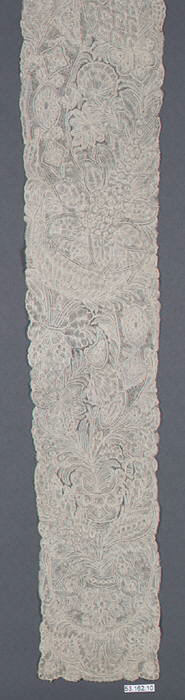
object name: lappet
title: Lappets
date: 1701-1733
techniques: lace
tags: flowers